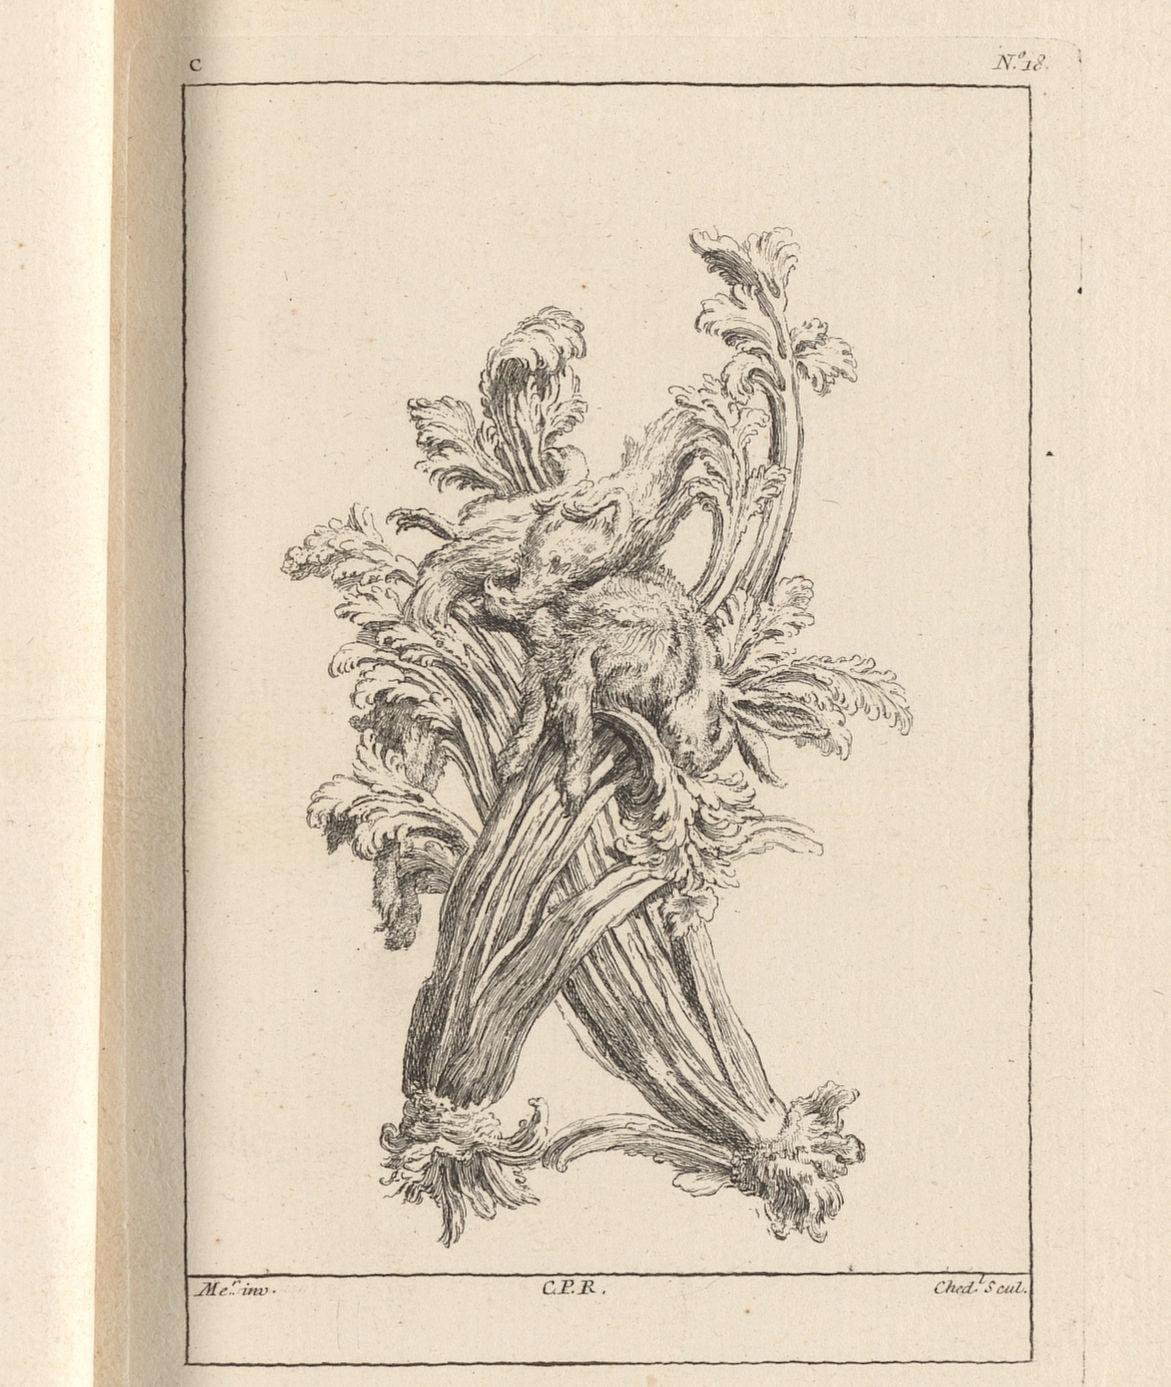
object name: print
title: Ornamenten en tafelschikkingen met groentes door Juste Aurele Meissonnier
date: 1738-1749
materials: paper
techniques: etching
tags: foodstuffs; still life of foodstuffs, rodents: rabbit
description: Prent uit een serie van zeven ornamentprenten met soortgelijke voorstellingen. Deze serie ( 'Livre de legumes') is onderdeel van de grotere reeks die het oeuvre van Meissonnier vertoont.